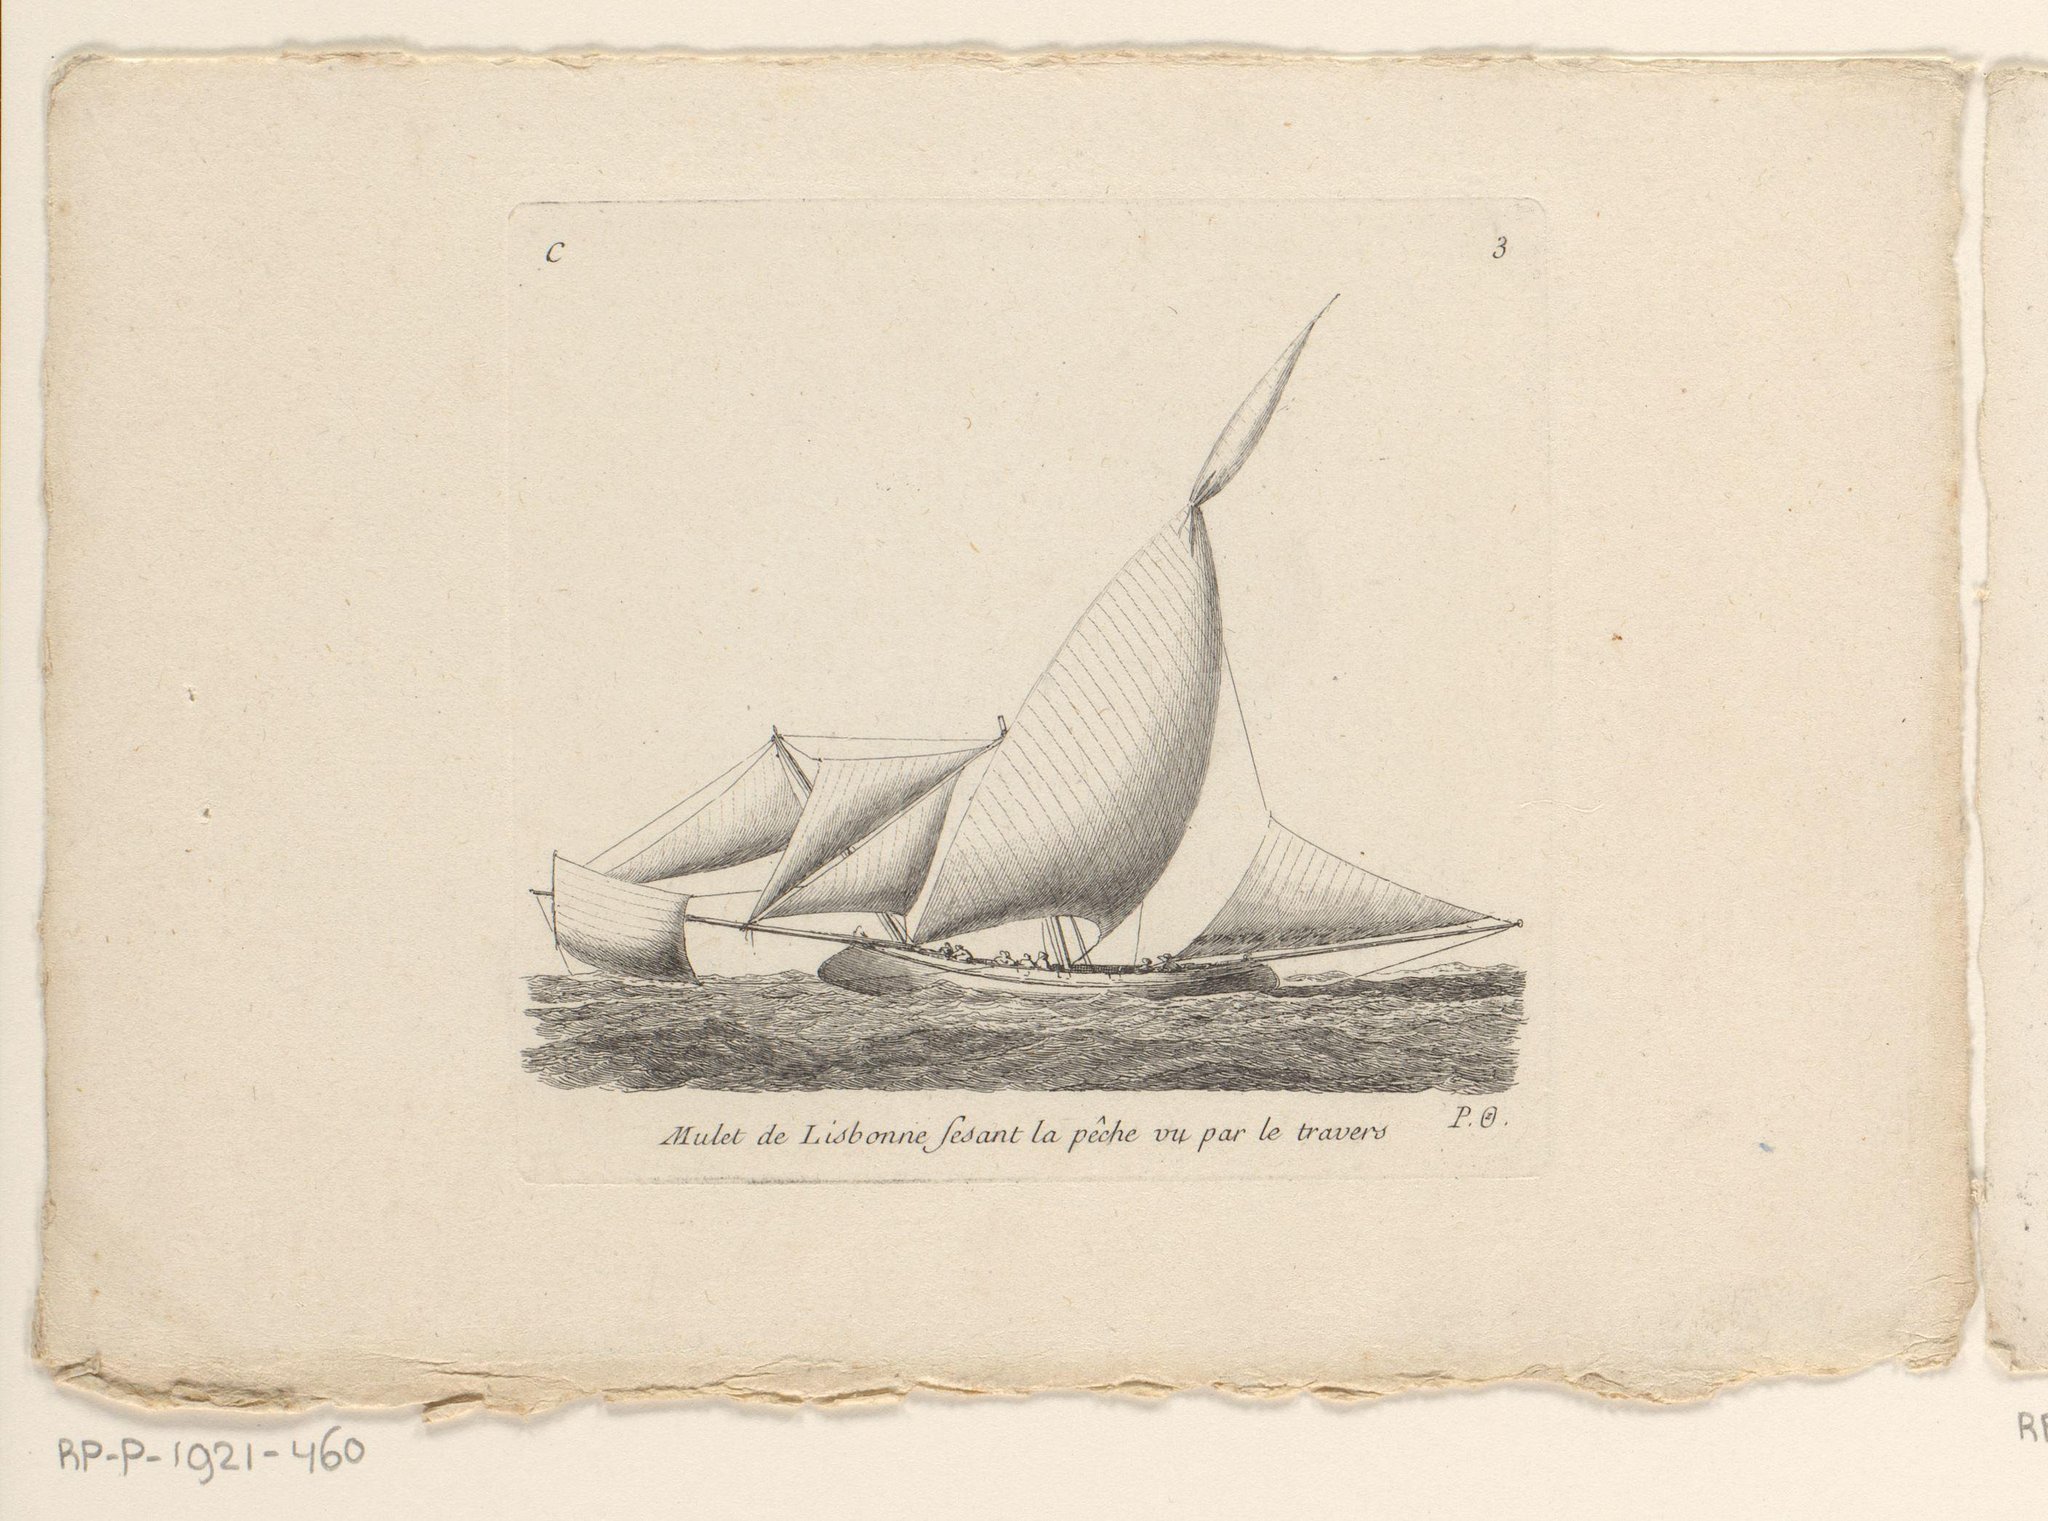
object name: print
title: Derde collectie schepen en boten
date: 1747-1813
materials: paper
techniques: etching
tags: commercial fishery, sailing-ship, sailing-boat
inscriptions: collector's mark: Lugt 2233